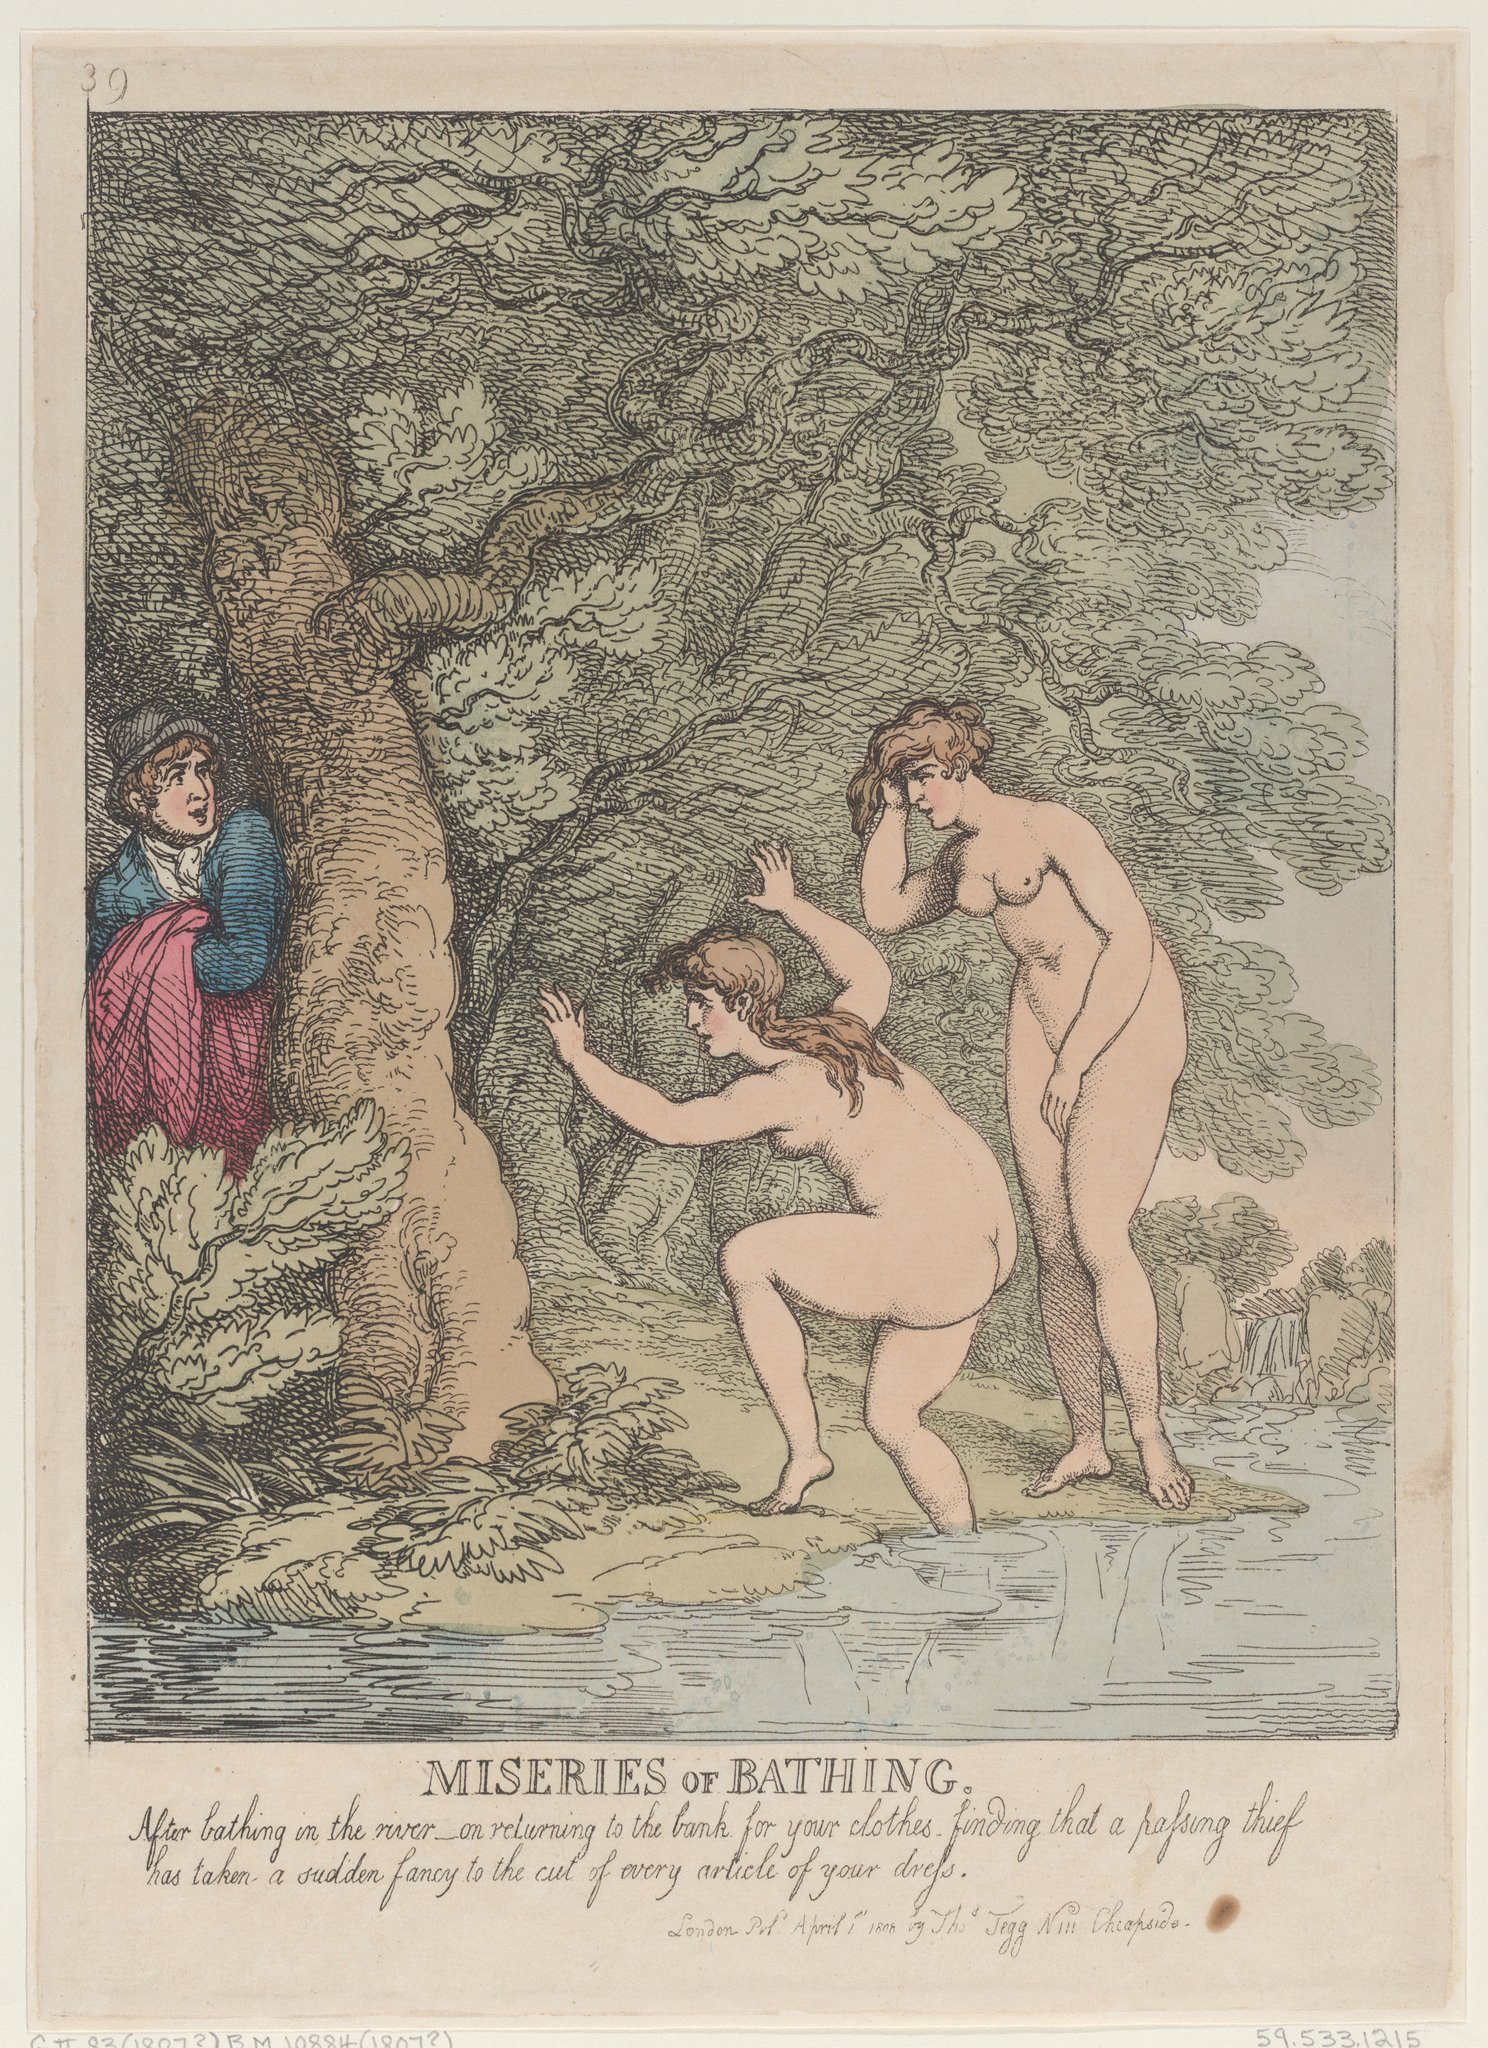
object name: print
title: Miseries of Bathing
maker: thomas rowlandson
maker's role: artist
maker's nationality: british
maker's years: 1757-1827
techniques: etching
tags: satire,men,women,female nudes,bathing